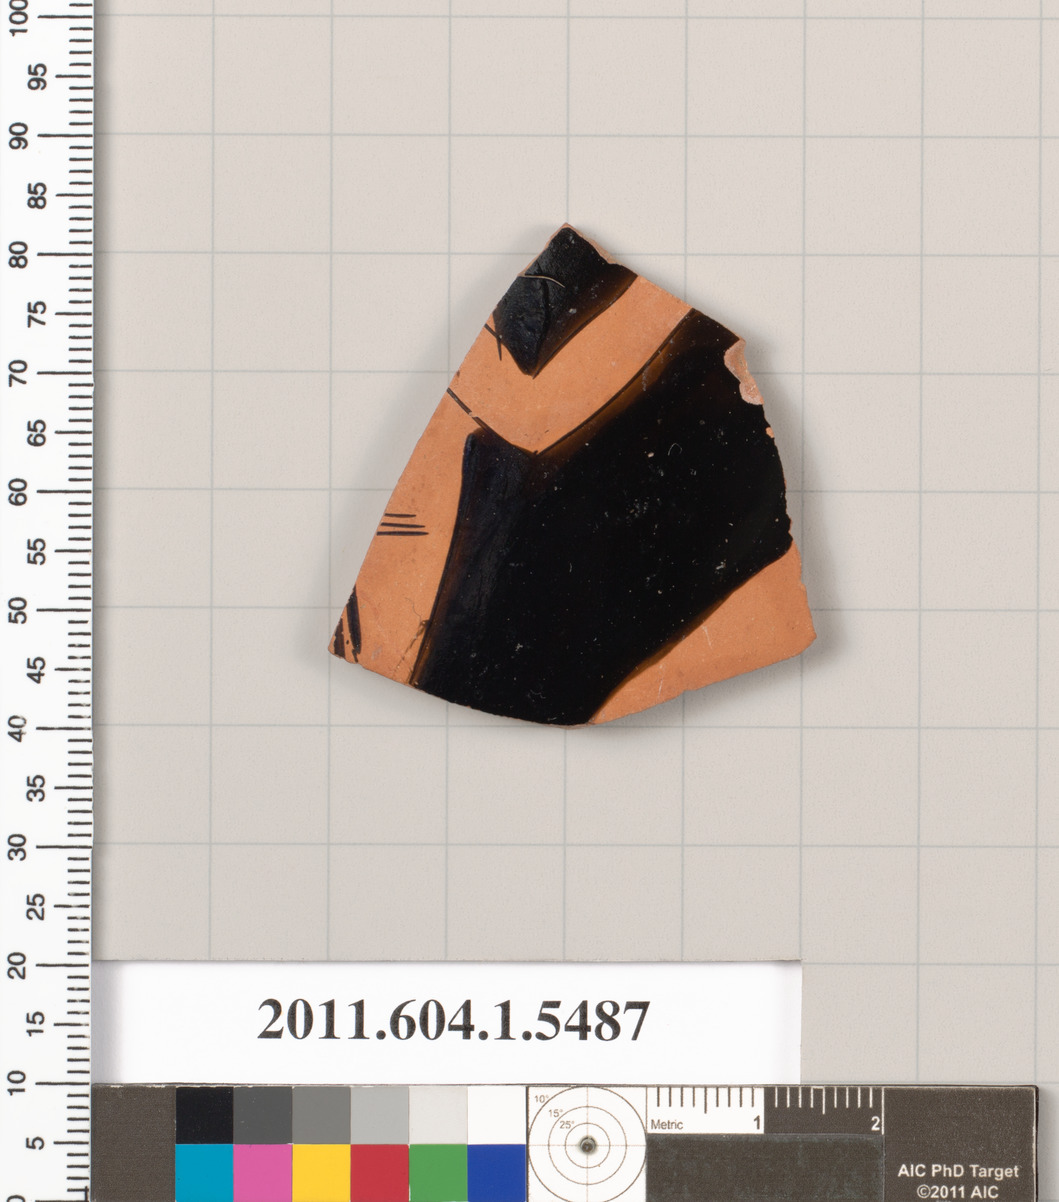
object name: kylix fragment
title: Terracotta fragment of a kylix (drinking cup)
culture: greek, attic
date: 500-480 BCE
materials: terracotta